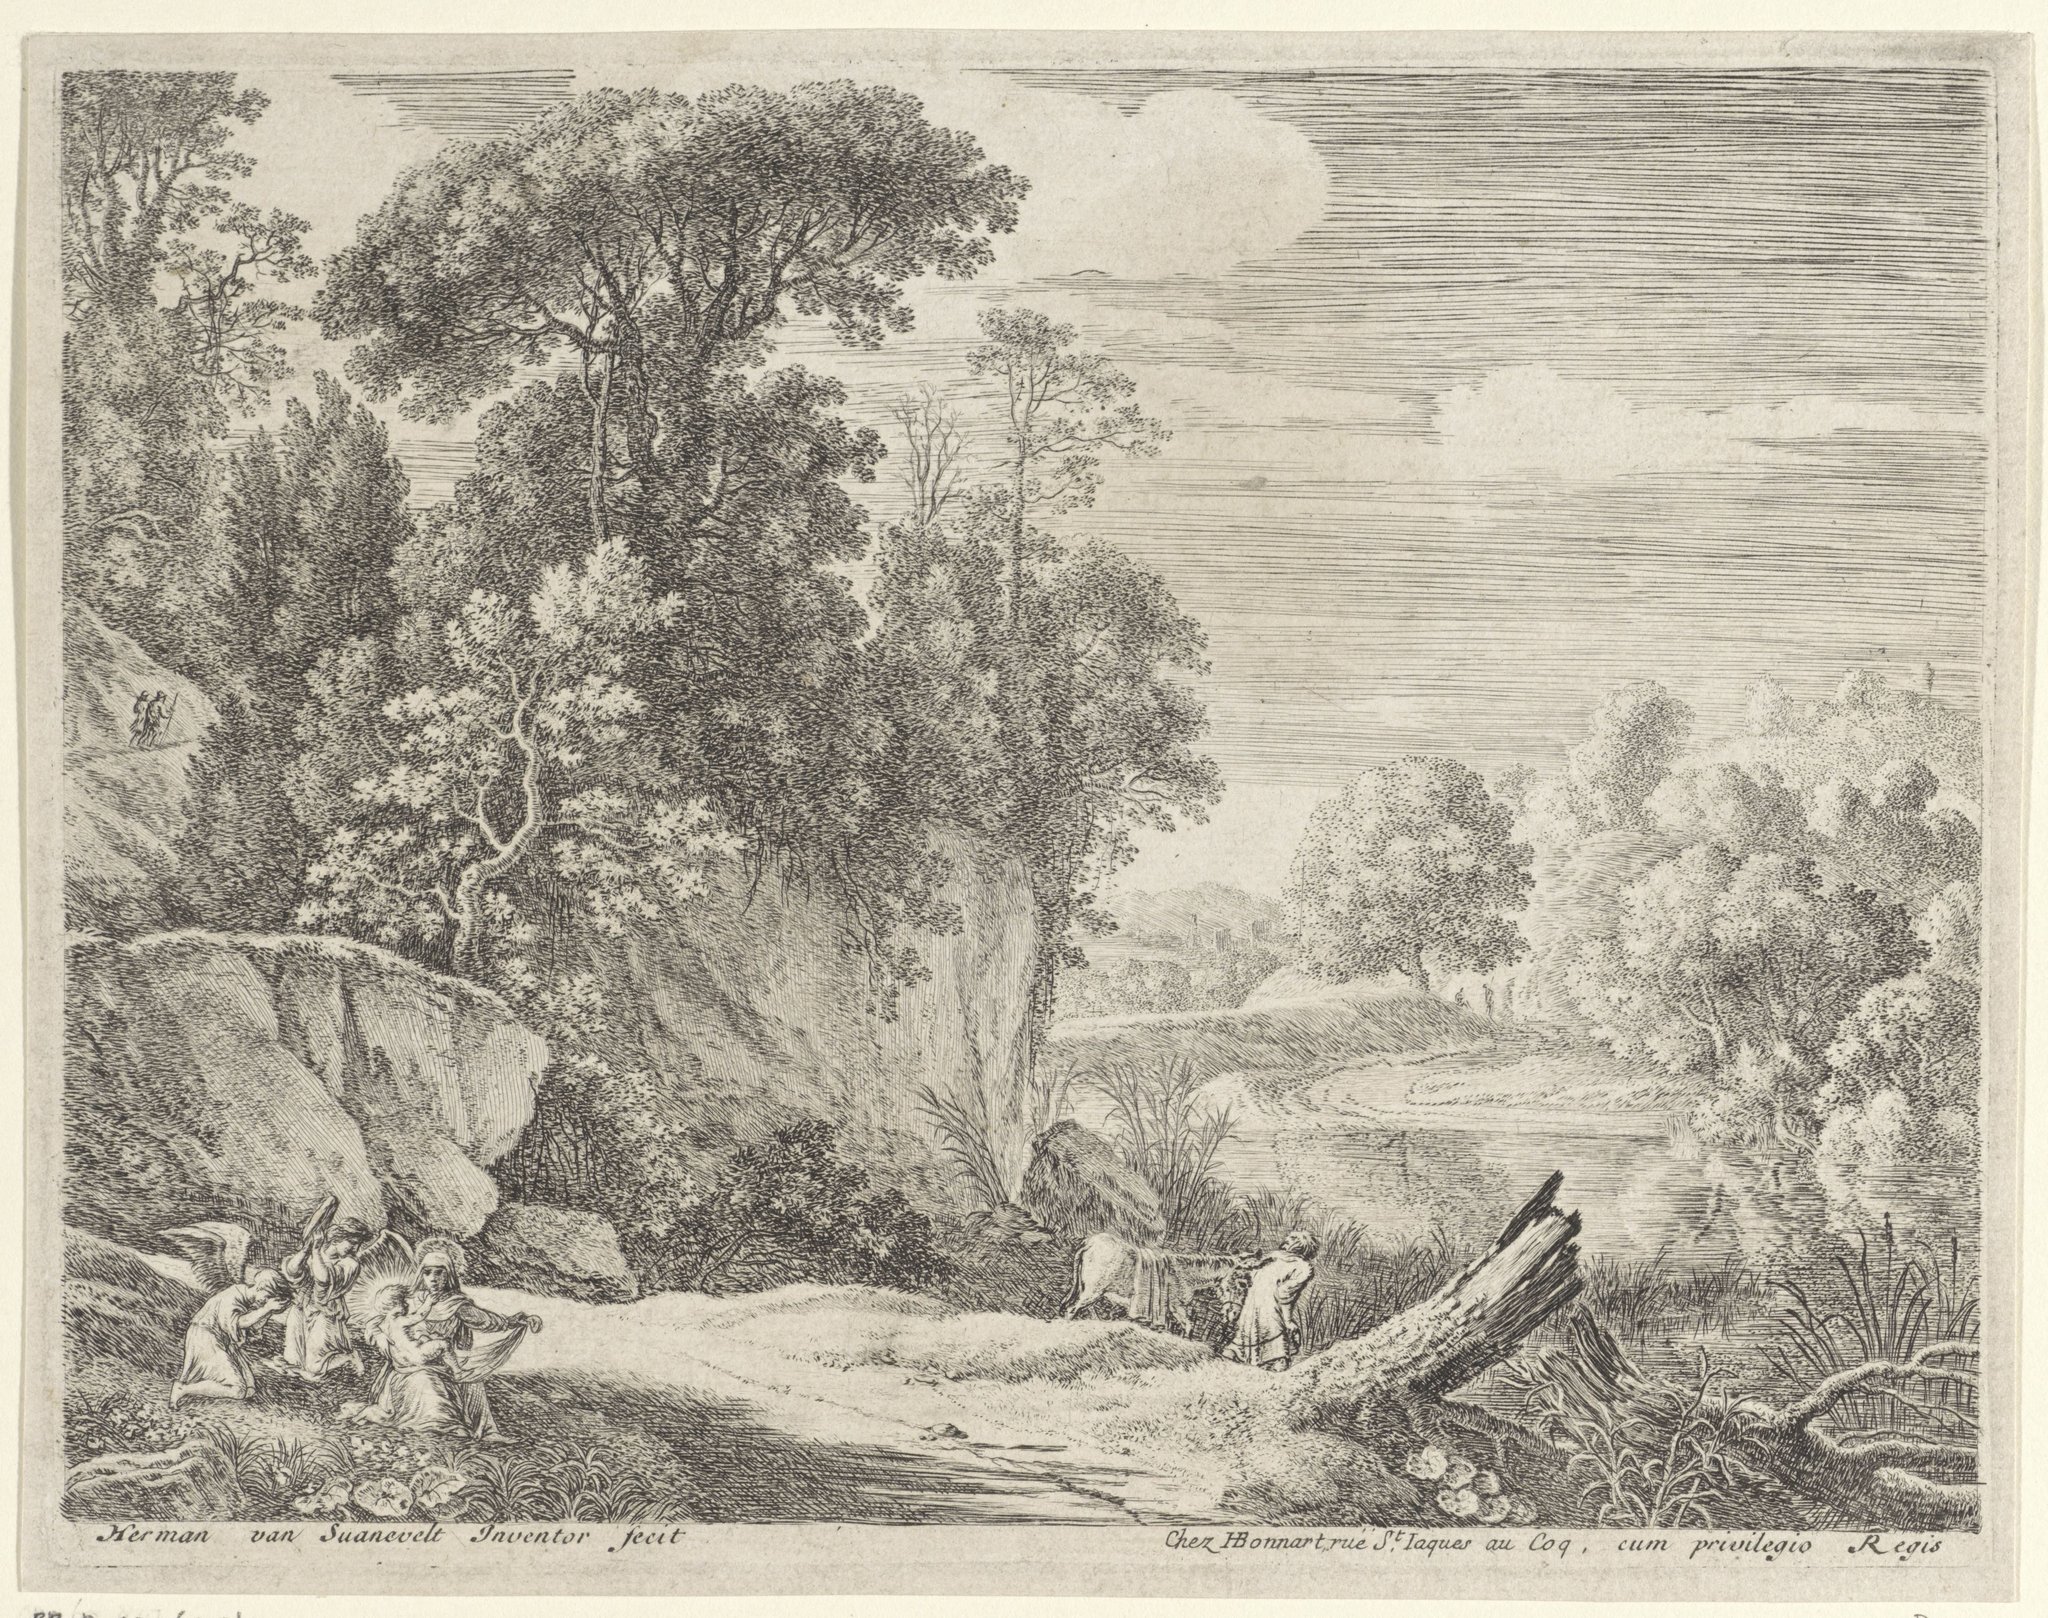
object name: print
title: Vlucht naar Egypte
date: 1643-1655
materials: paper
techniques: etching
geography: paris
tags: rest on the flight into egypt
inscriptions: collector's mark: Lugt 2228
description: Er is een rotsachtig landschap met een rivier weergegeven. Links op de voorgrond knielt Maria met Christus op haar schoot. Naast haar knielen twee engelen, van wie de achterste een slaginstrument bespeelt. Achter hen leidt Jozef de ezel naar de rivier.